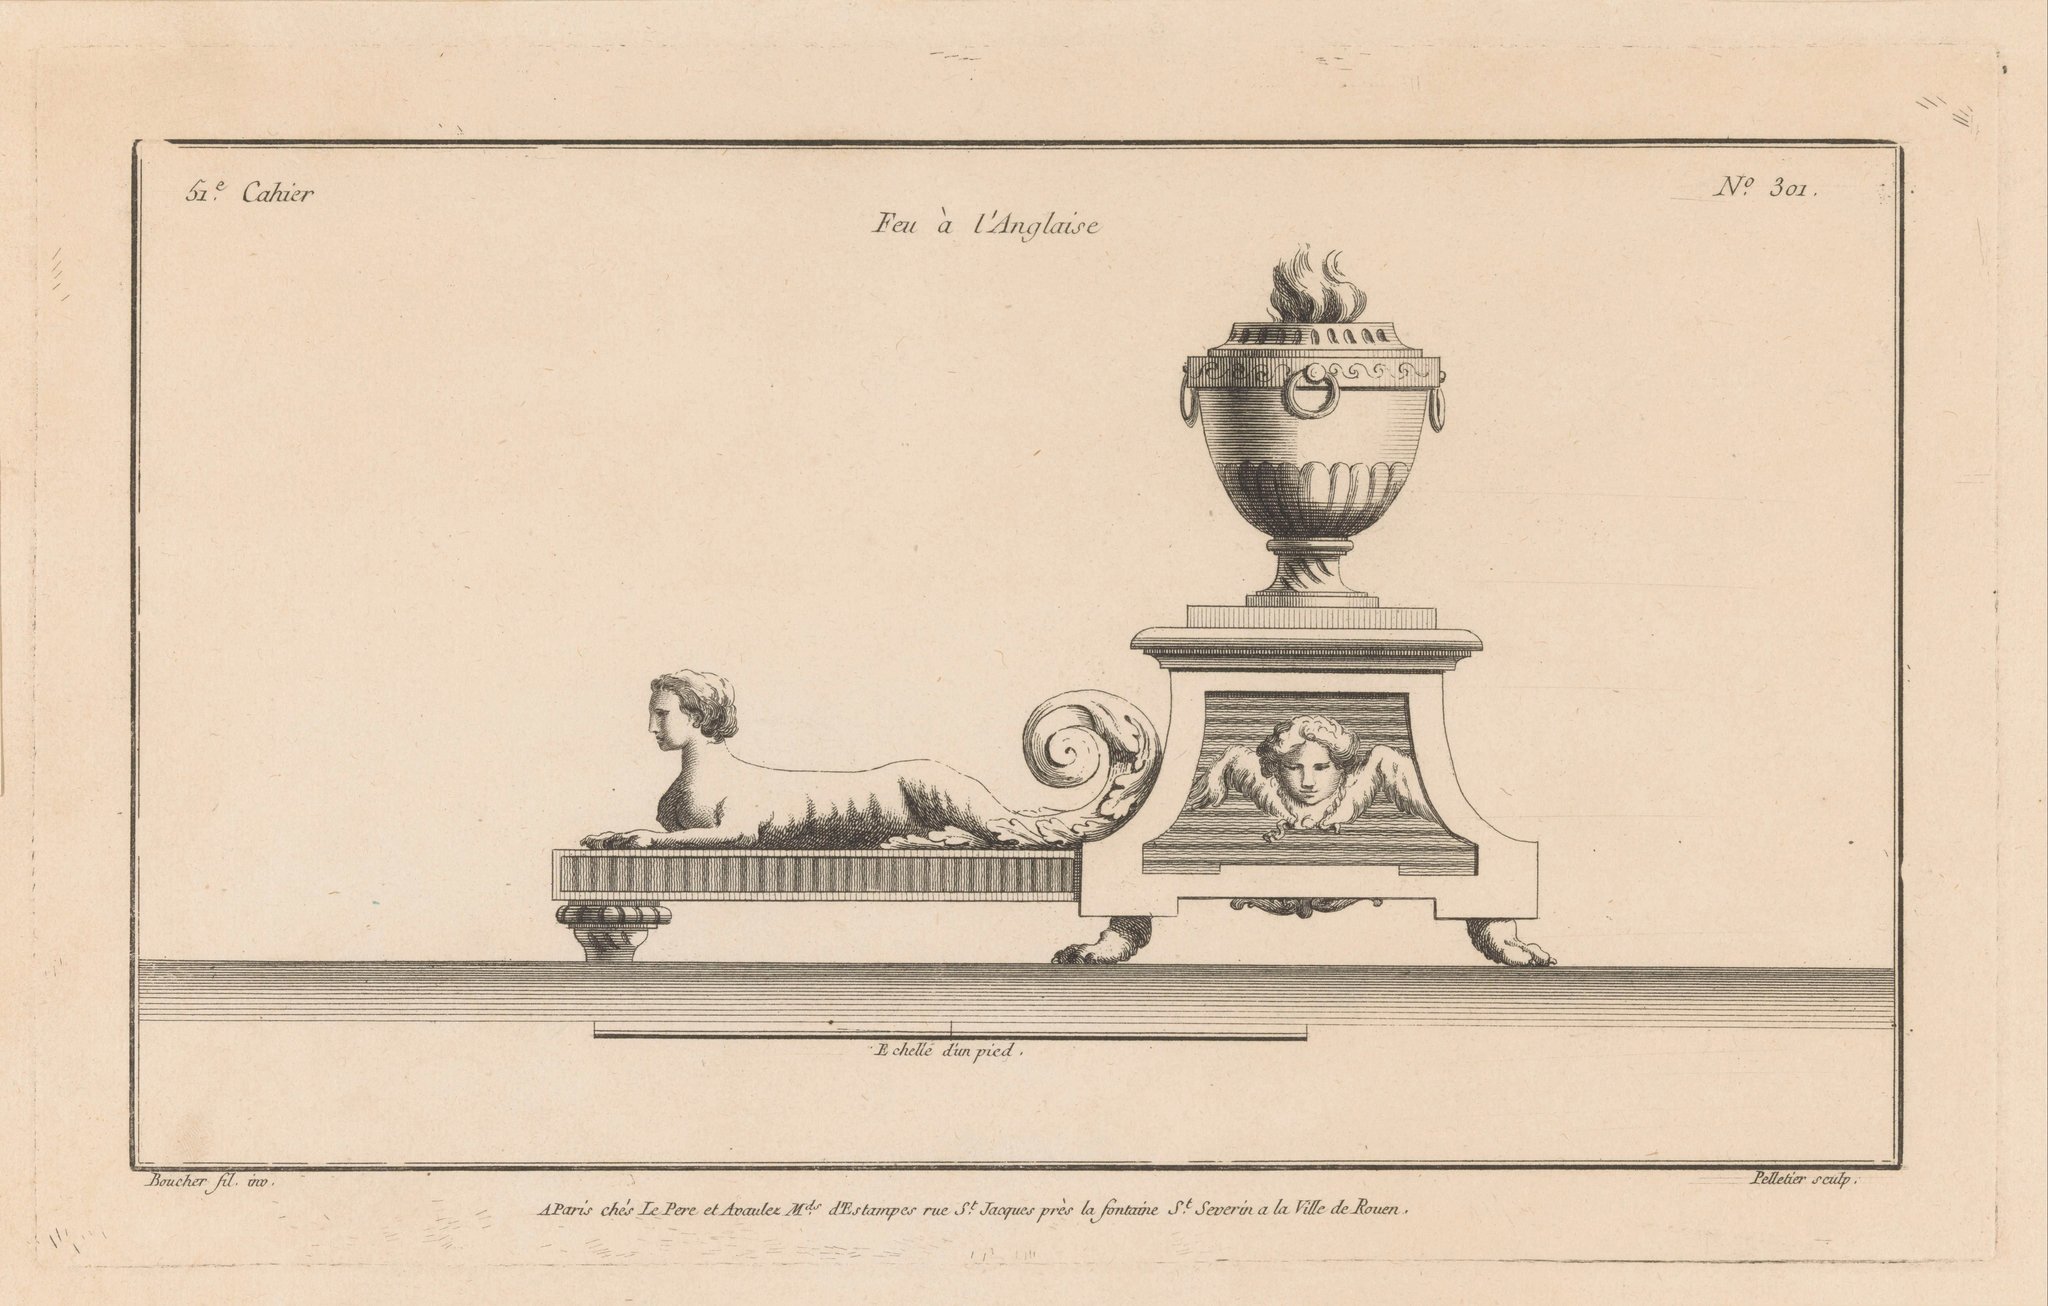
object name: ornament print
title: Vuurbokken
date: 1772-1779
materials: paper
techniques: engraving, etching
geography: paris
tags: sphinx (lion/woman); 'sfinge' (ripa), andiron, fire-dog, vase ~ ornament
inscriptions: collector's mark: Lugt 2760, collector's mark: Lugt 2228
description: Een geornamenteerde vuurbok met een sfinx, de staart in een ornament eindigend, en een vaas met vuur. Prentnummer 301.